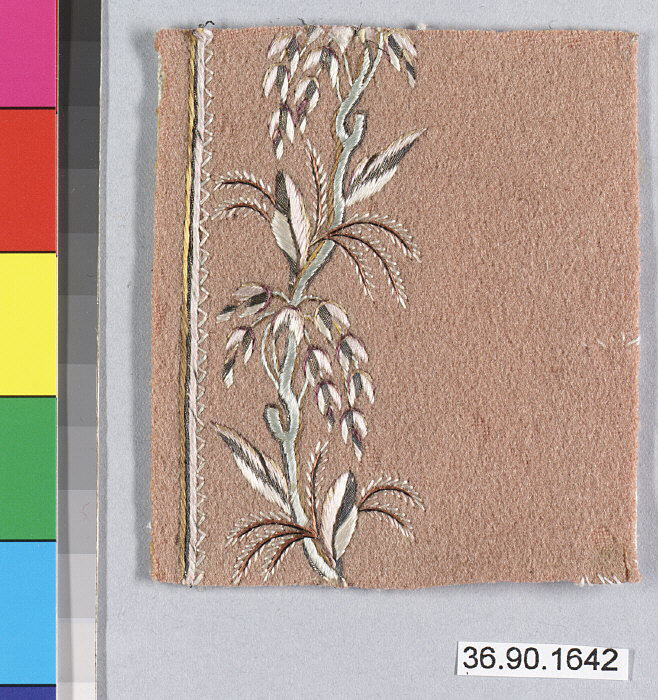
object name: sample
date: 1801-1833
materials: felt, metal thread, silk